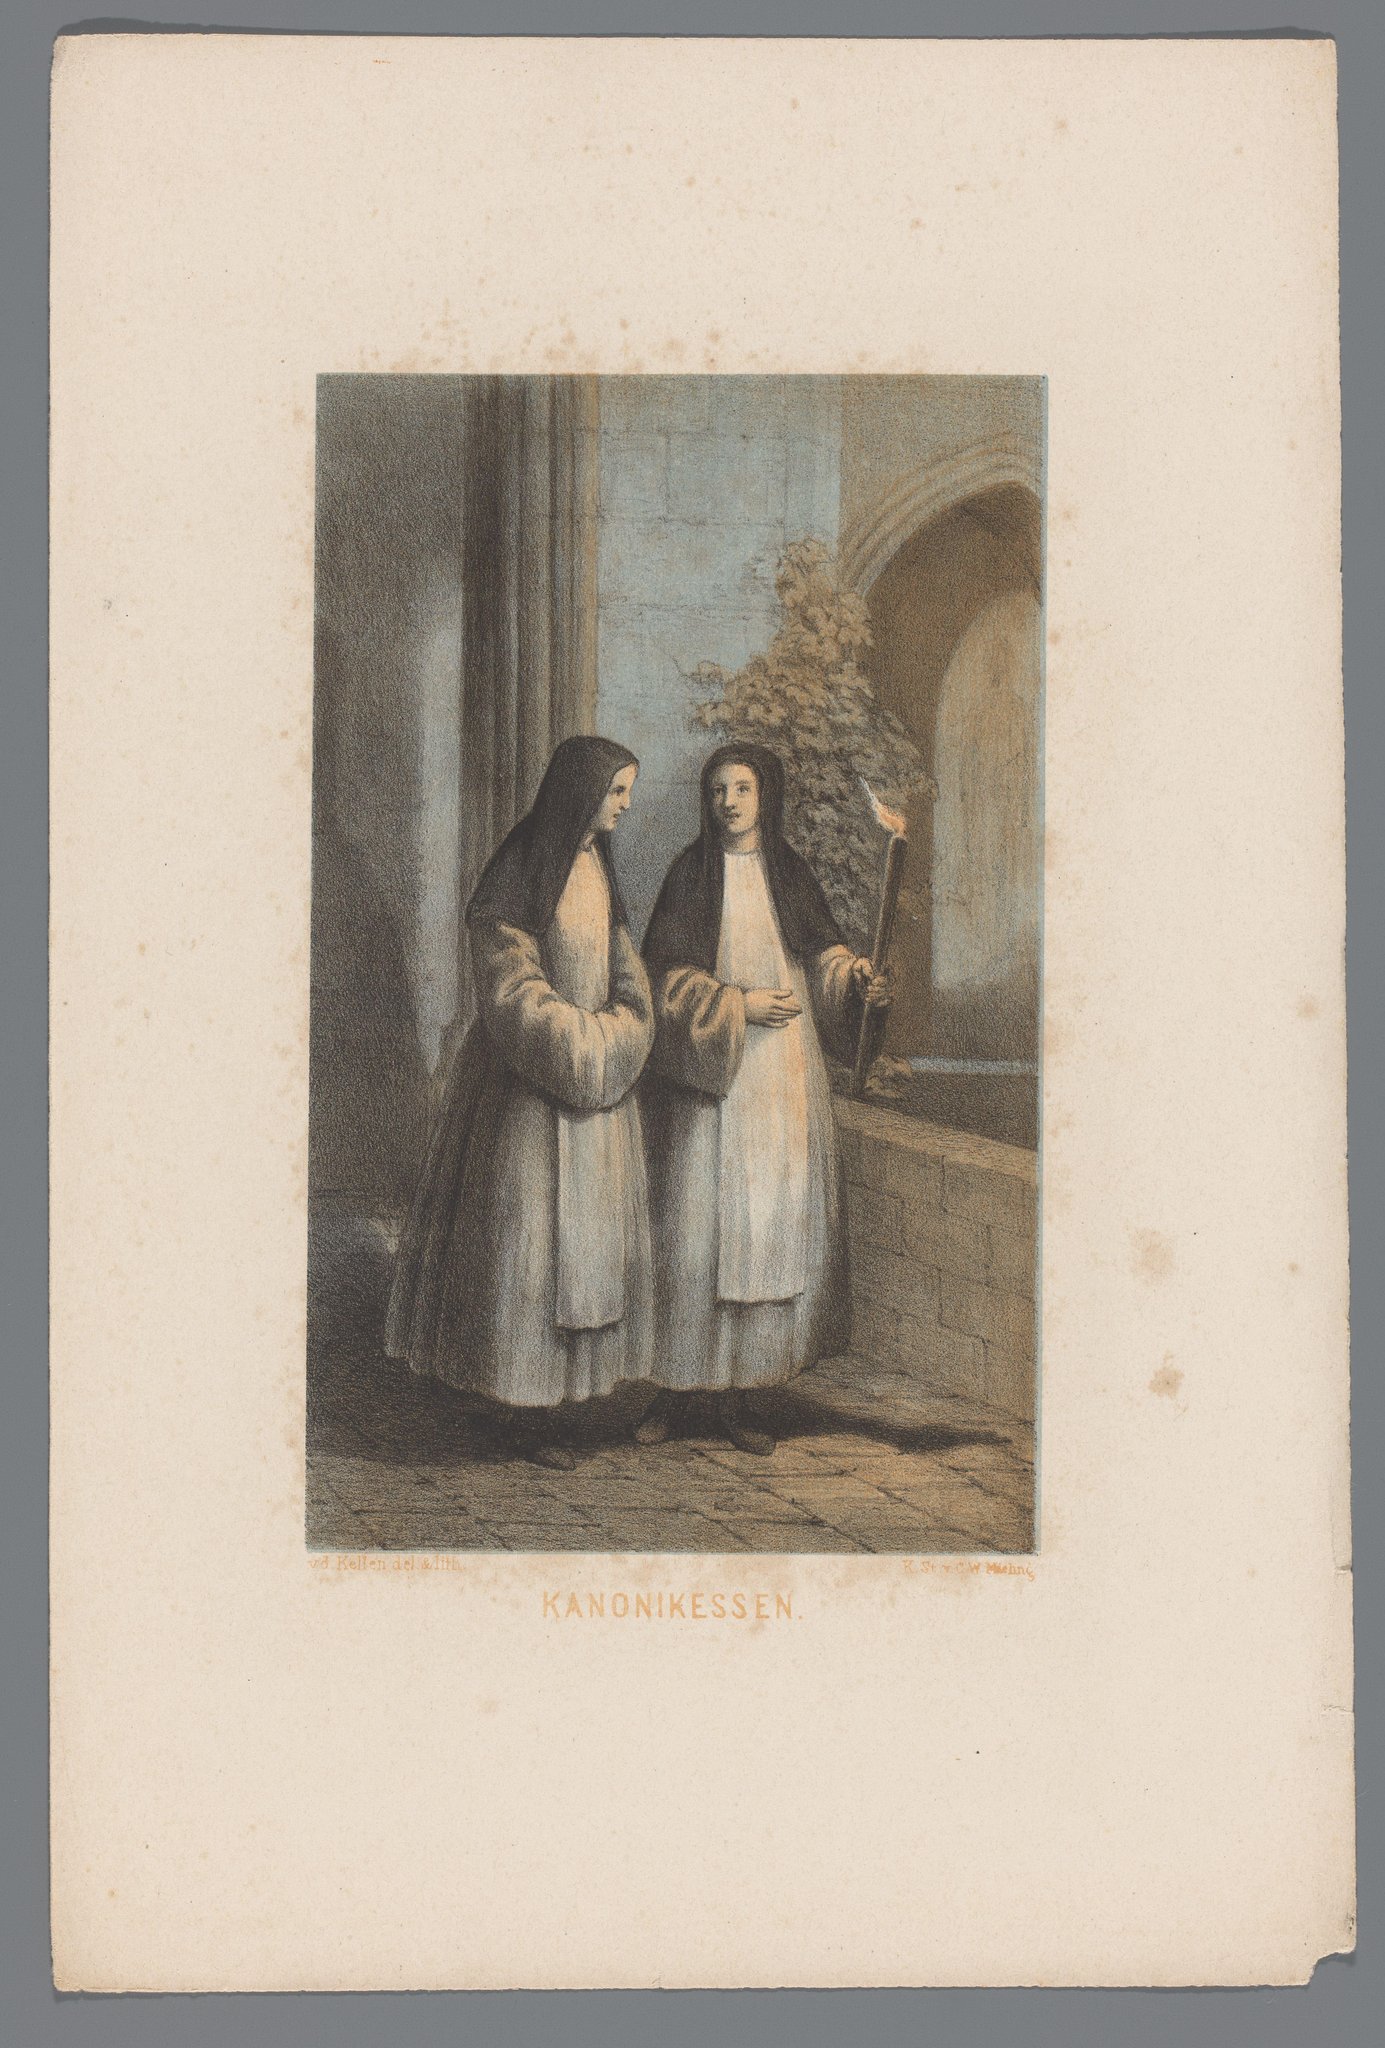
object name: print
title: Kanonikessen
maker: david van der kellen (1827-1895)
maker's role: draughtsman, print maker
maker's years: 1827-1895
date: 1865-1874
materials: paper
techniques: tone lithography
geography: the hague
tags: torch, nun(s)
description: De prent is zonder het adres van C.W. Mieling gebruikt in: Hofdijk, W.J. De klooster-orden in Nederland. Haarlem: A.C. Kruseman, 1865. En in de editie van 1874.